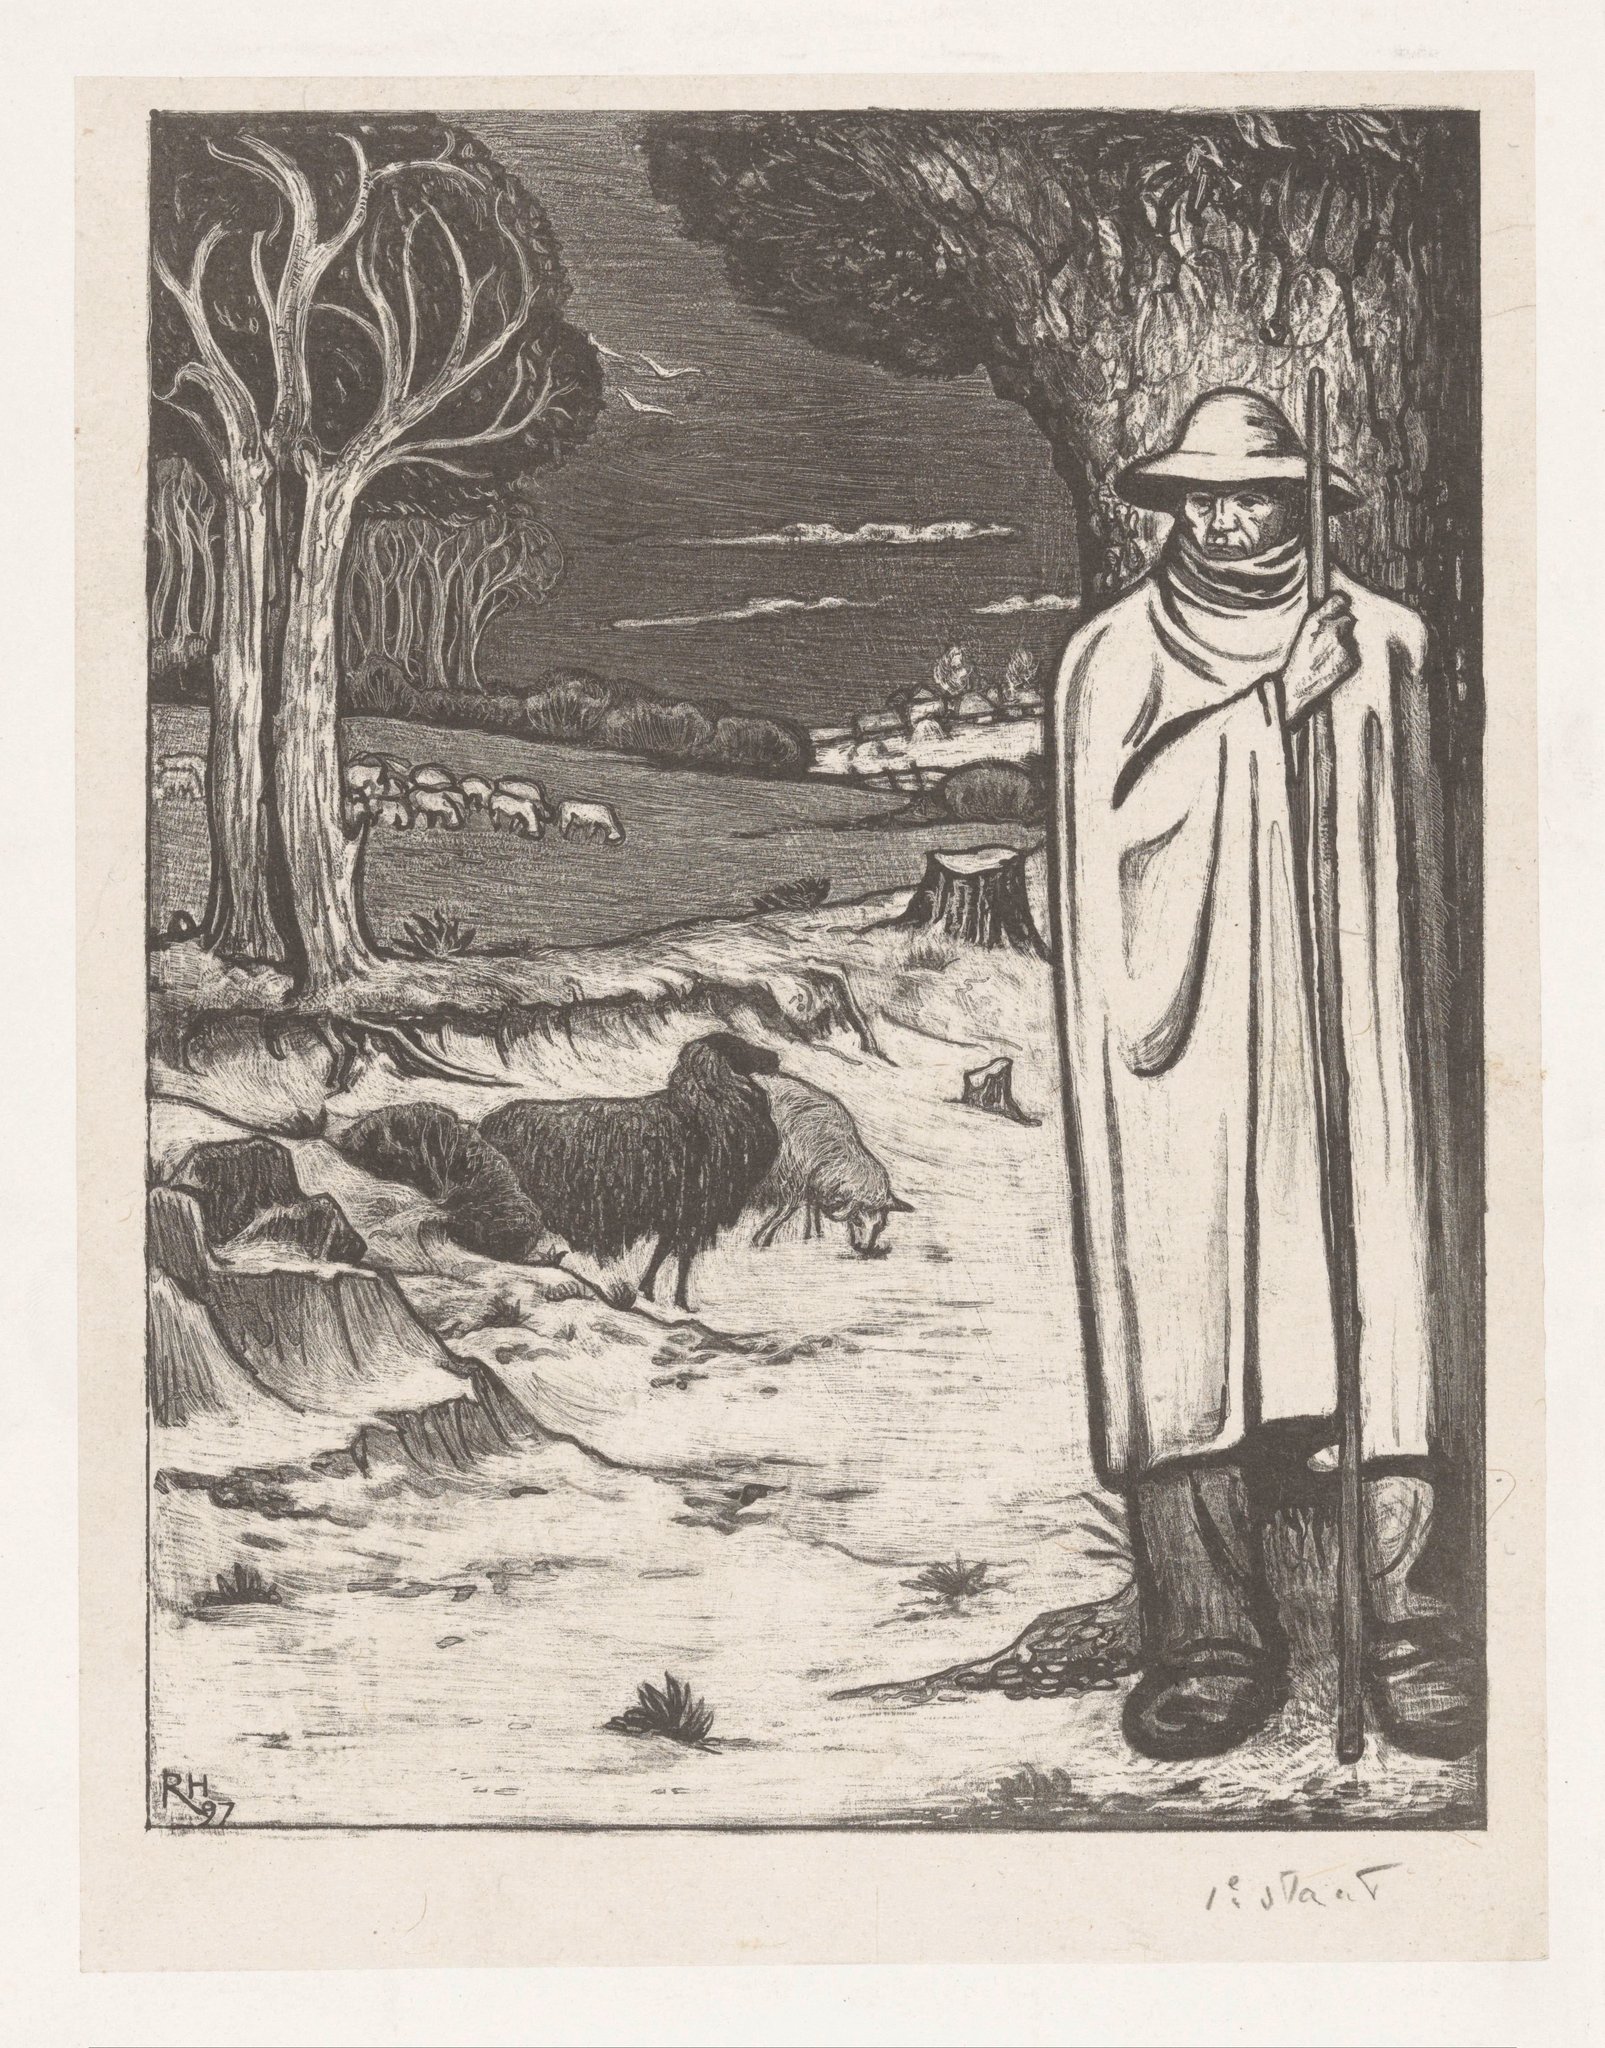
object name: print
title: Herder met een kudde schapen in een heuvellandschap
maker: richard nicolaüs roland holst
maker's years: 1868-1938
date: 1897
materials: paper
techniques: lithograph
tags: herding, herdsman, herdswoman, shepherd, shepherdess, cowherd, etc., sheep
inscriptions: collector's mark: Lugt 2228